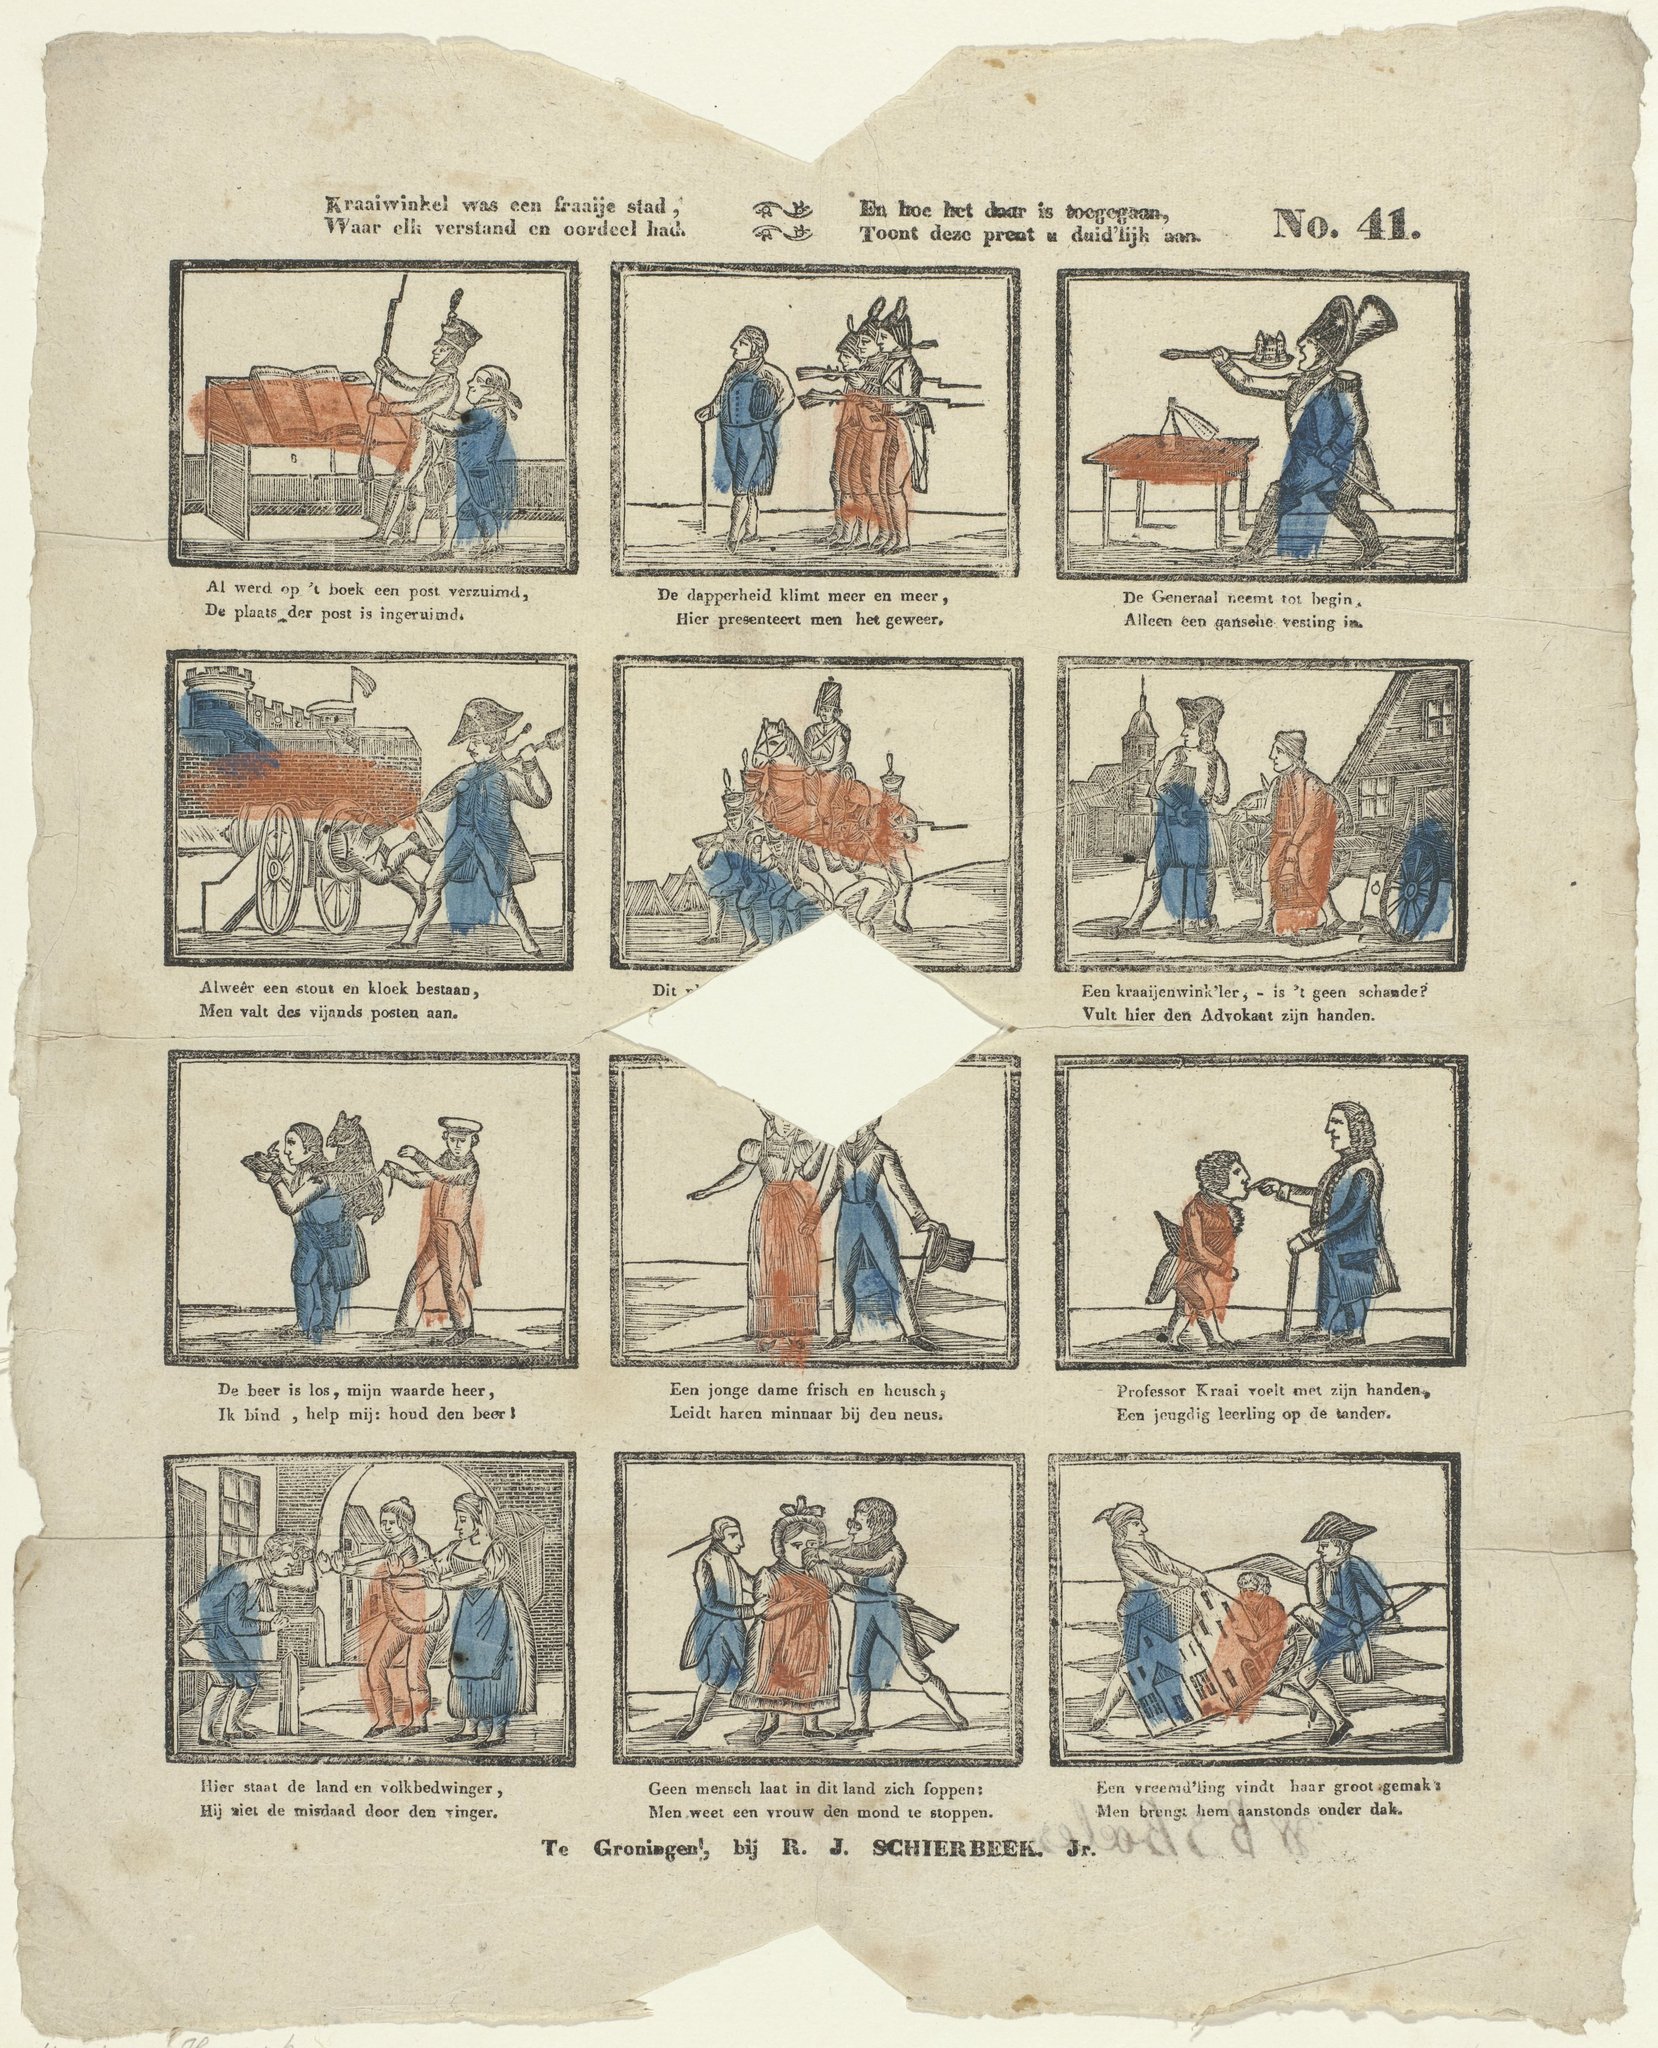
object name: popular print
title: Kraaiwinkel was een fraaije stad, / Waar elk verstand en oordeel had. / En hoe het daar is toegegaan, / Toont deze prent u duid'lijk aan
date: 1832-1850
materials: paper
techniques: colour, letterpress printing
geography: rotterdam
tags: the soldier; the soldier's life, couple of lovers, criminals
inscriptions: inscription: ‘W B S Boeles.’, collector's mark: Lugt 2760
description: Blad met 12 voorstellingen van verschillende figuren, waaronder militairen, een misdadiger en een jonge dame en haar minnaar. Onder elke afbeelding een tweeregelig vers. Genummerd rechtsboven: No. 41.